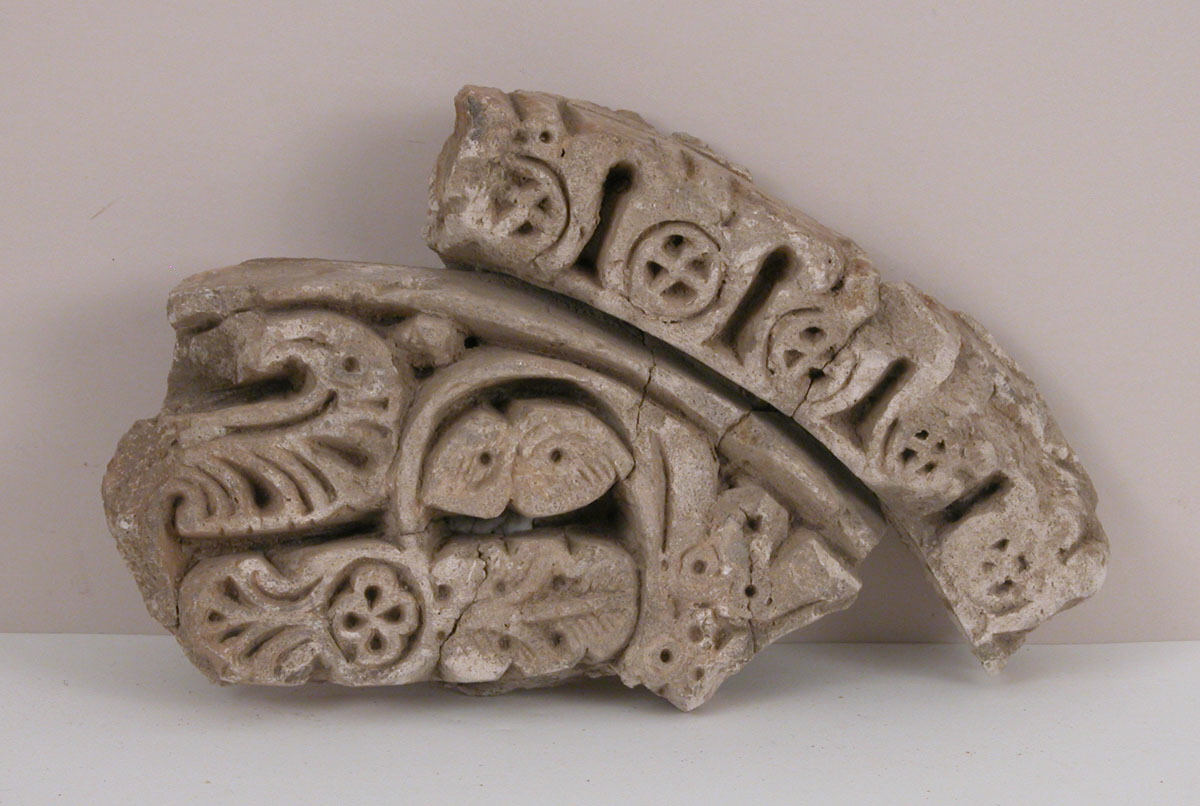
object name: fragment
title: Stucco Fragment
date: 801-900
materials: plaster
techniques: molding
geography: iran